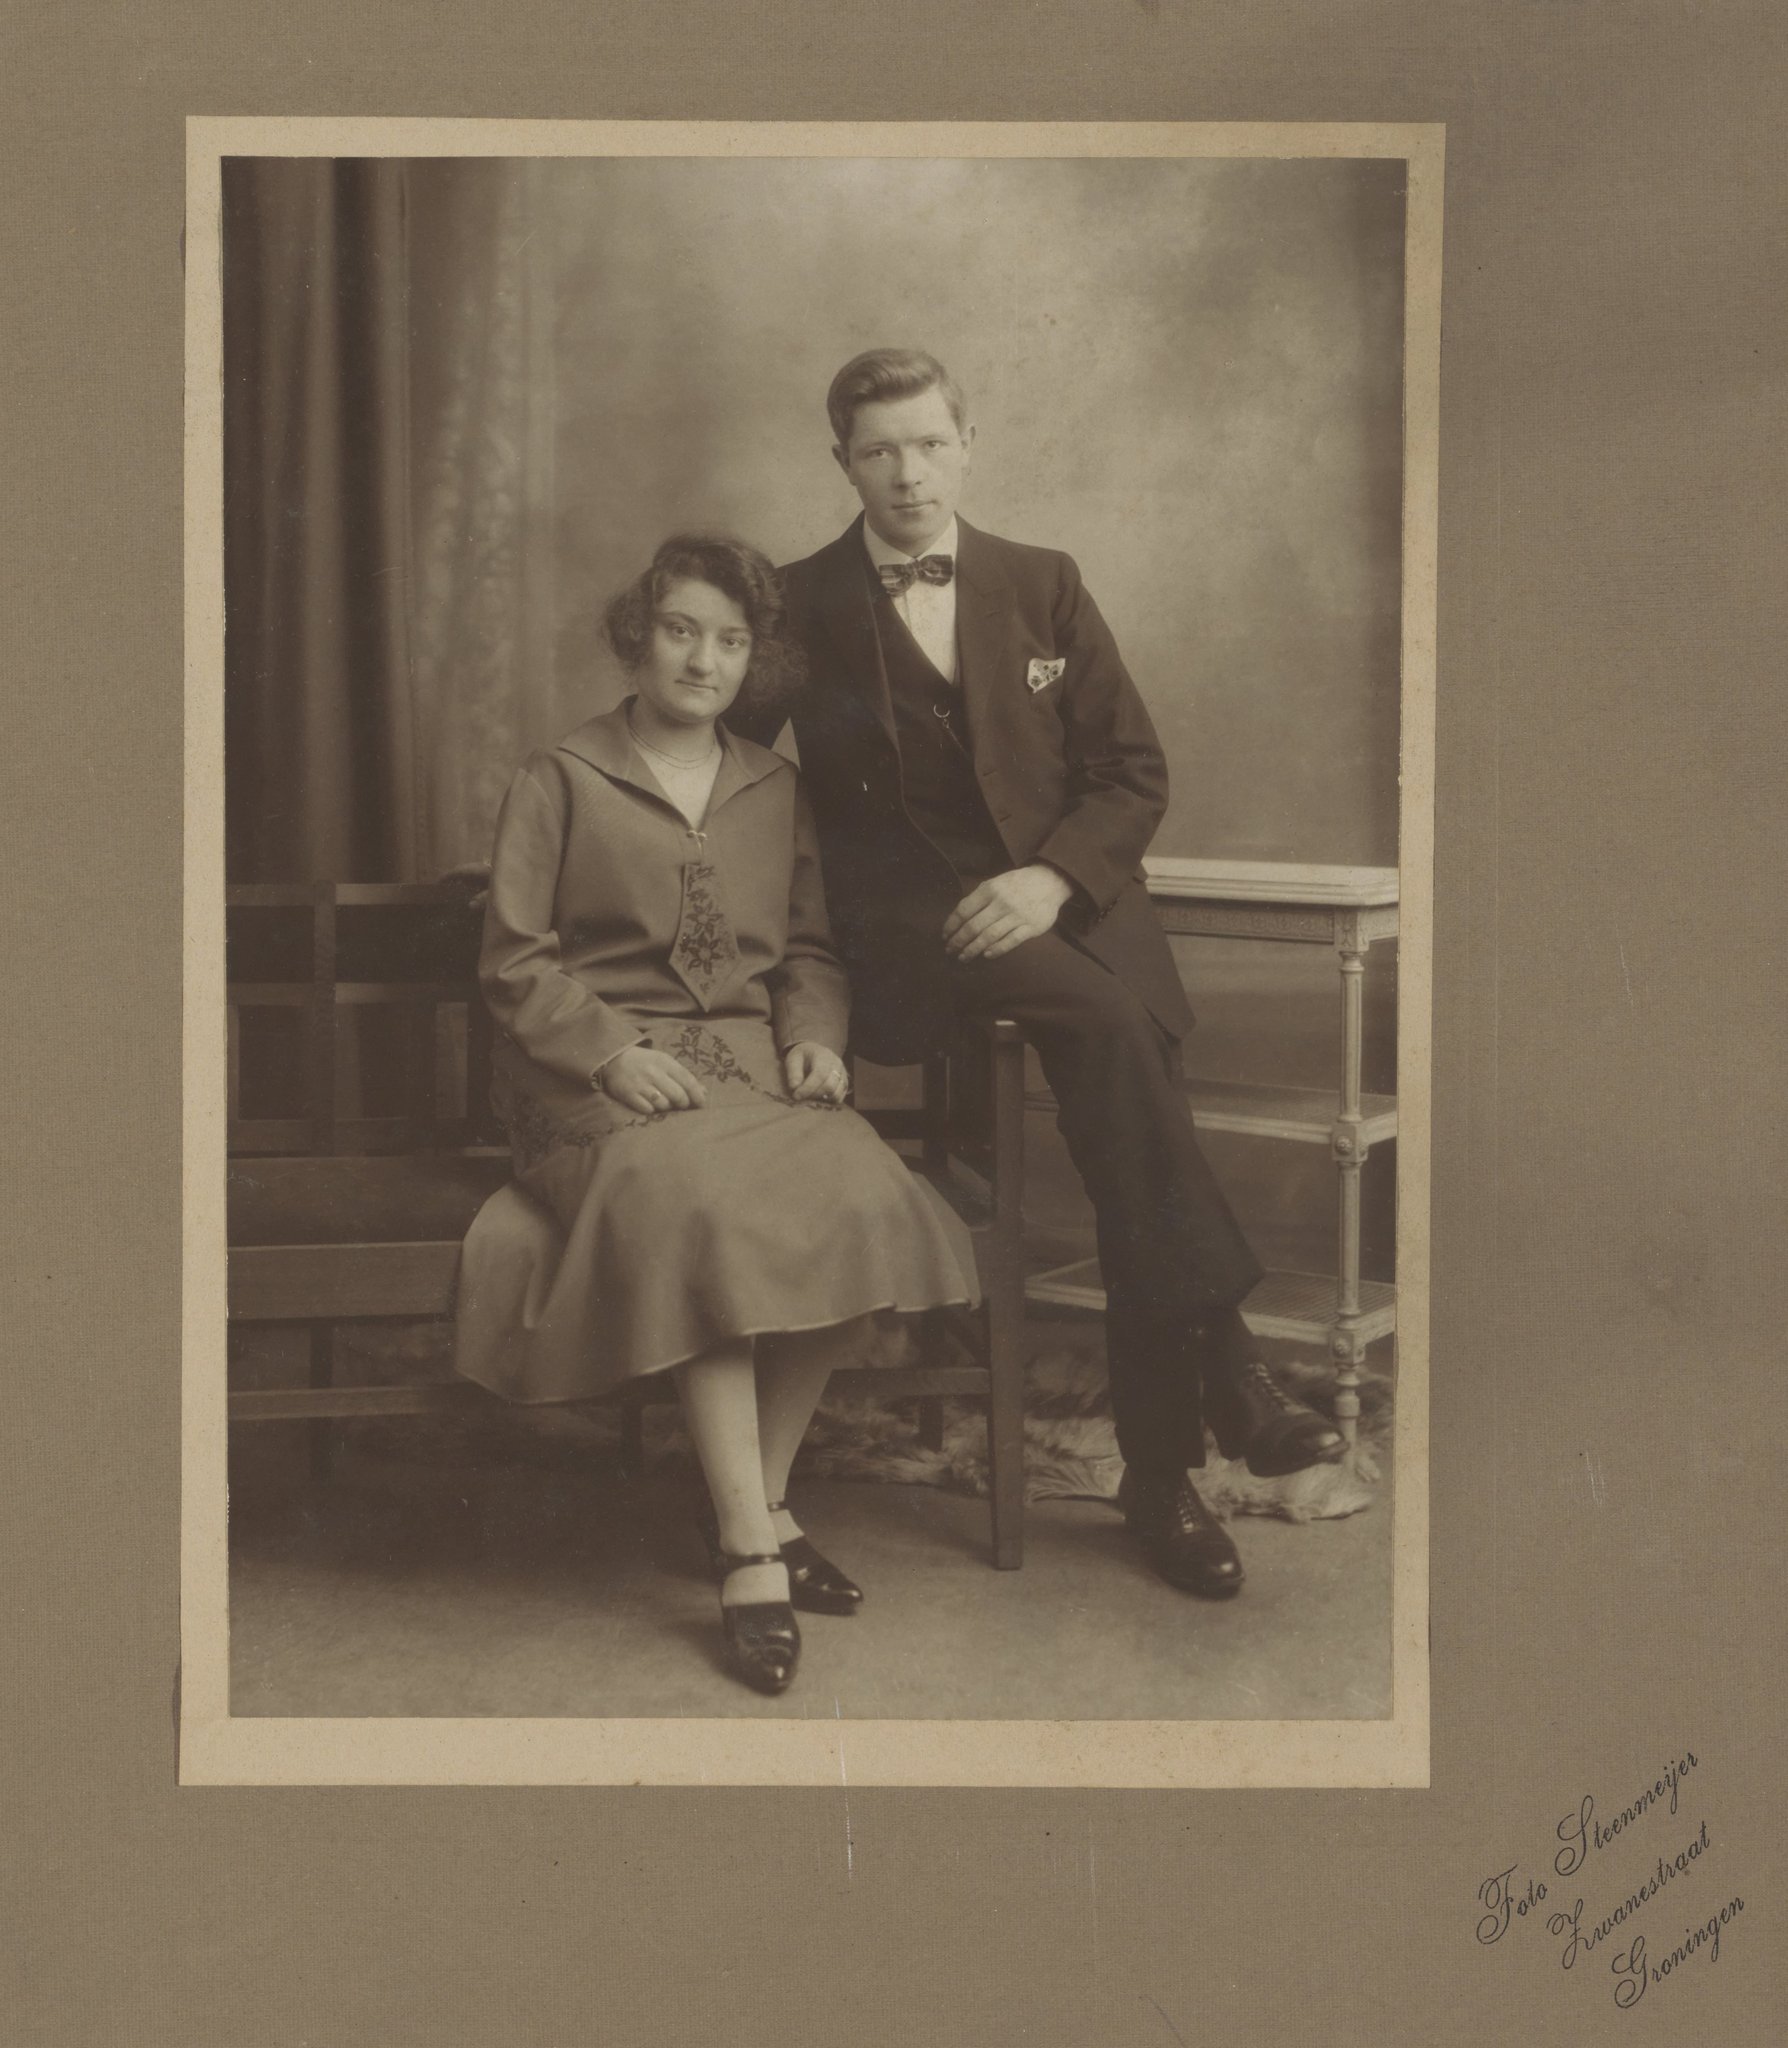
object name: photograph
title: Portret van een man en een vrouw op een bank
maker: johannes adrianus steenmeijer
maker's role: fotograaf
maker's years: 1856-1935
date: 1915-1926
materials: cardboard, paper, photographic support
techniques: gelatin silver print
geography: groningen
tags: adult woman, adult man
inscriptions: address: ‘Zwanestraat Groningen’